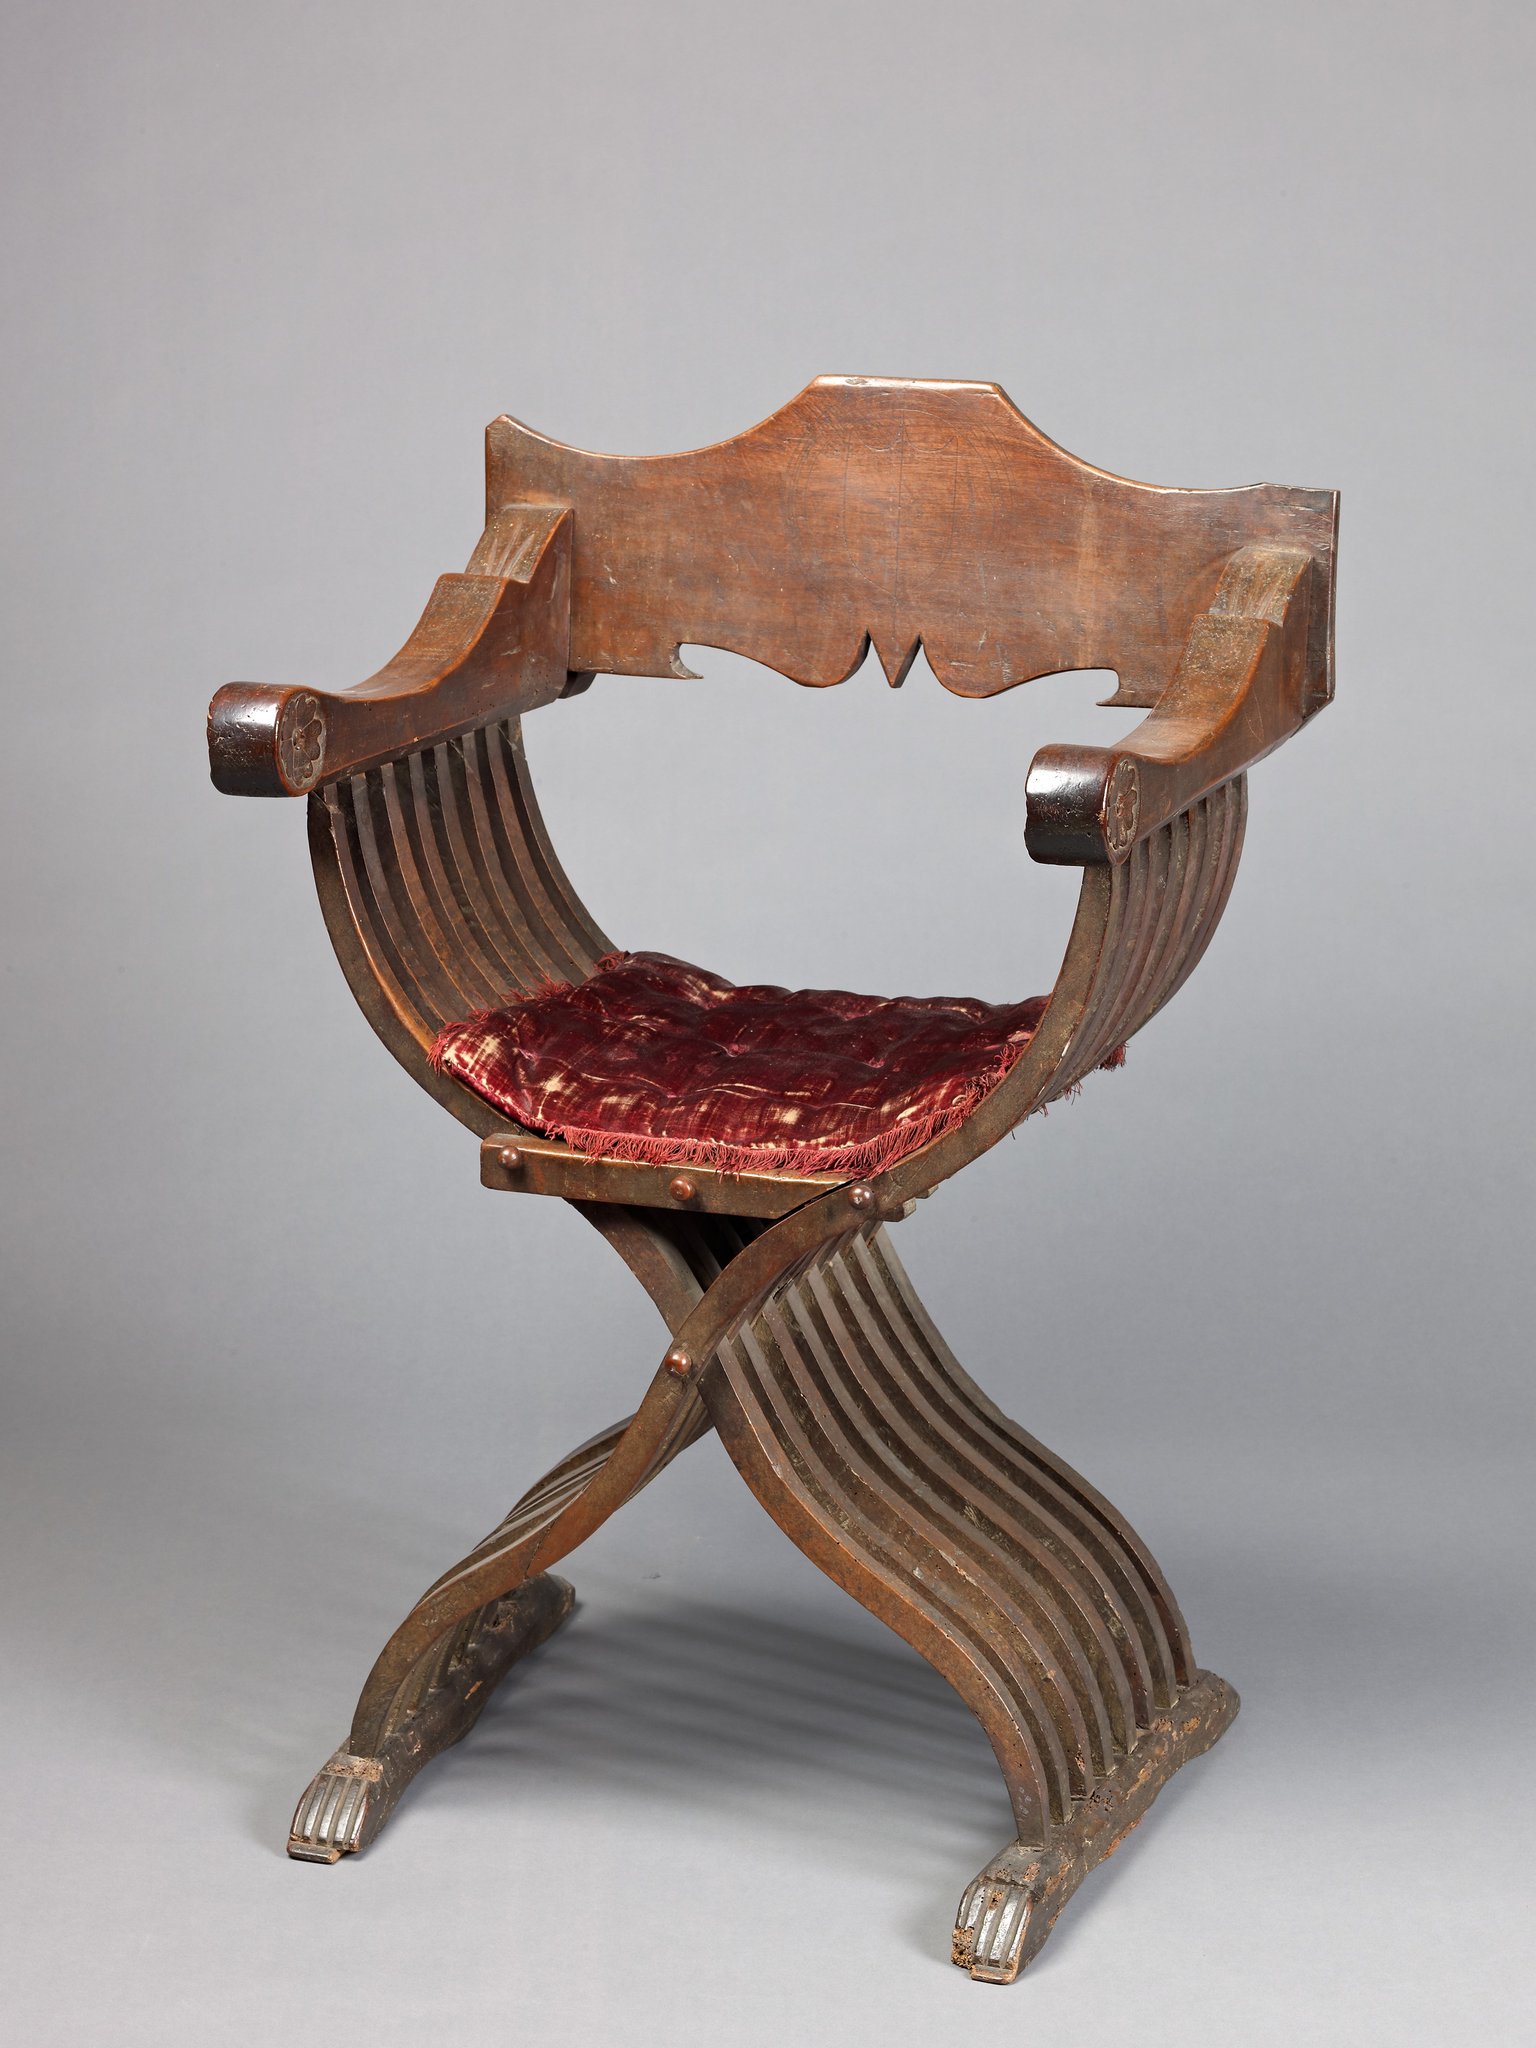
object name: armchair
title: Folding armchair (sedia a Savonarola type)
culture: italian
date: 1401-1500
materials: velvet, wood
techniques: carving